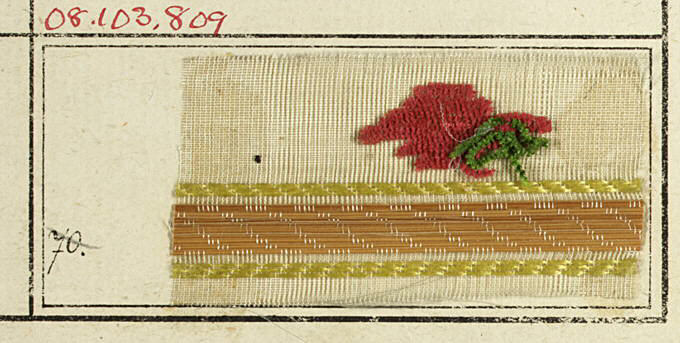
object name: ribbon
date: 1701-1900